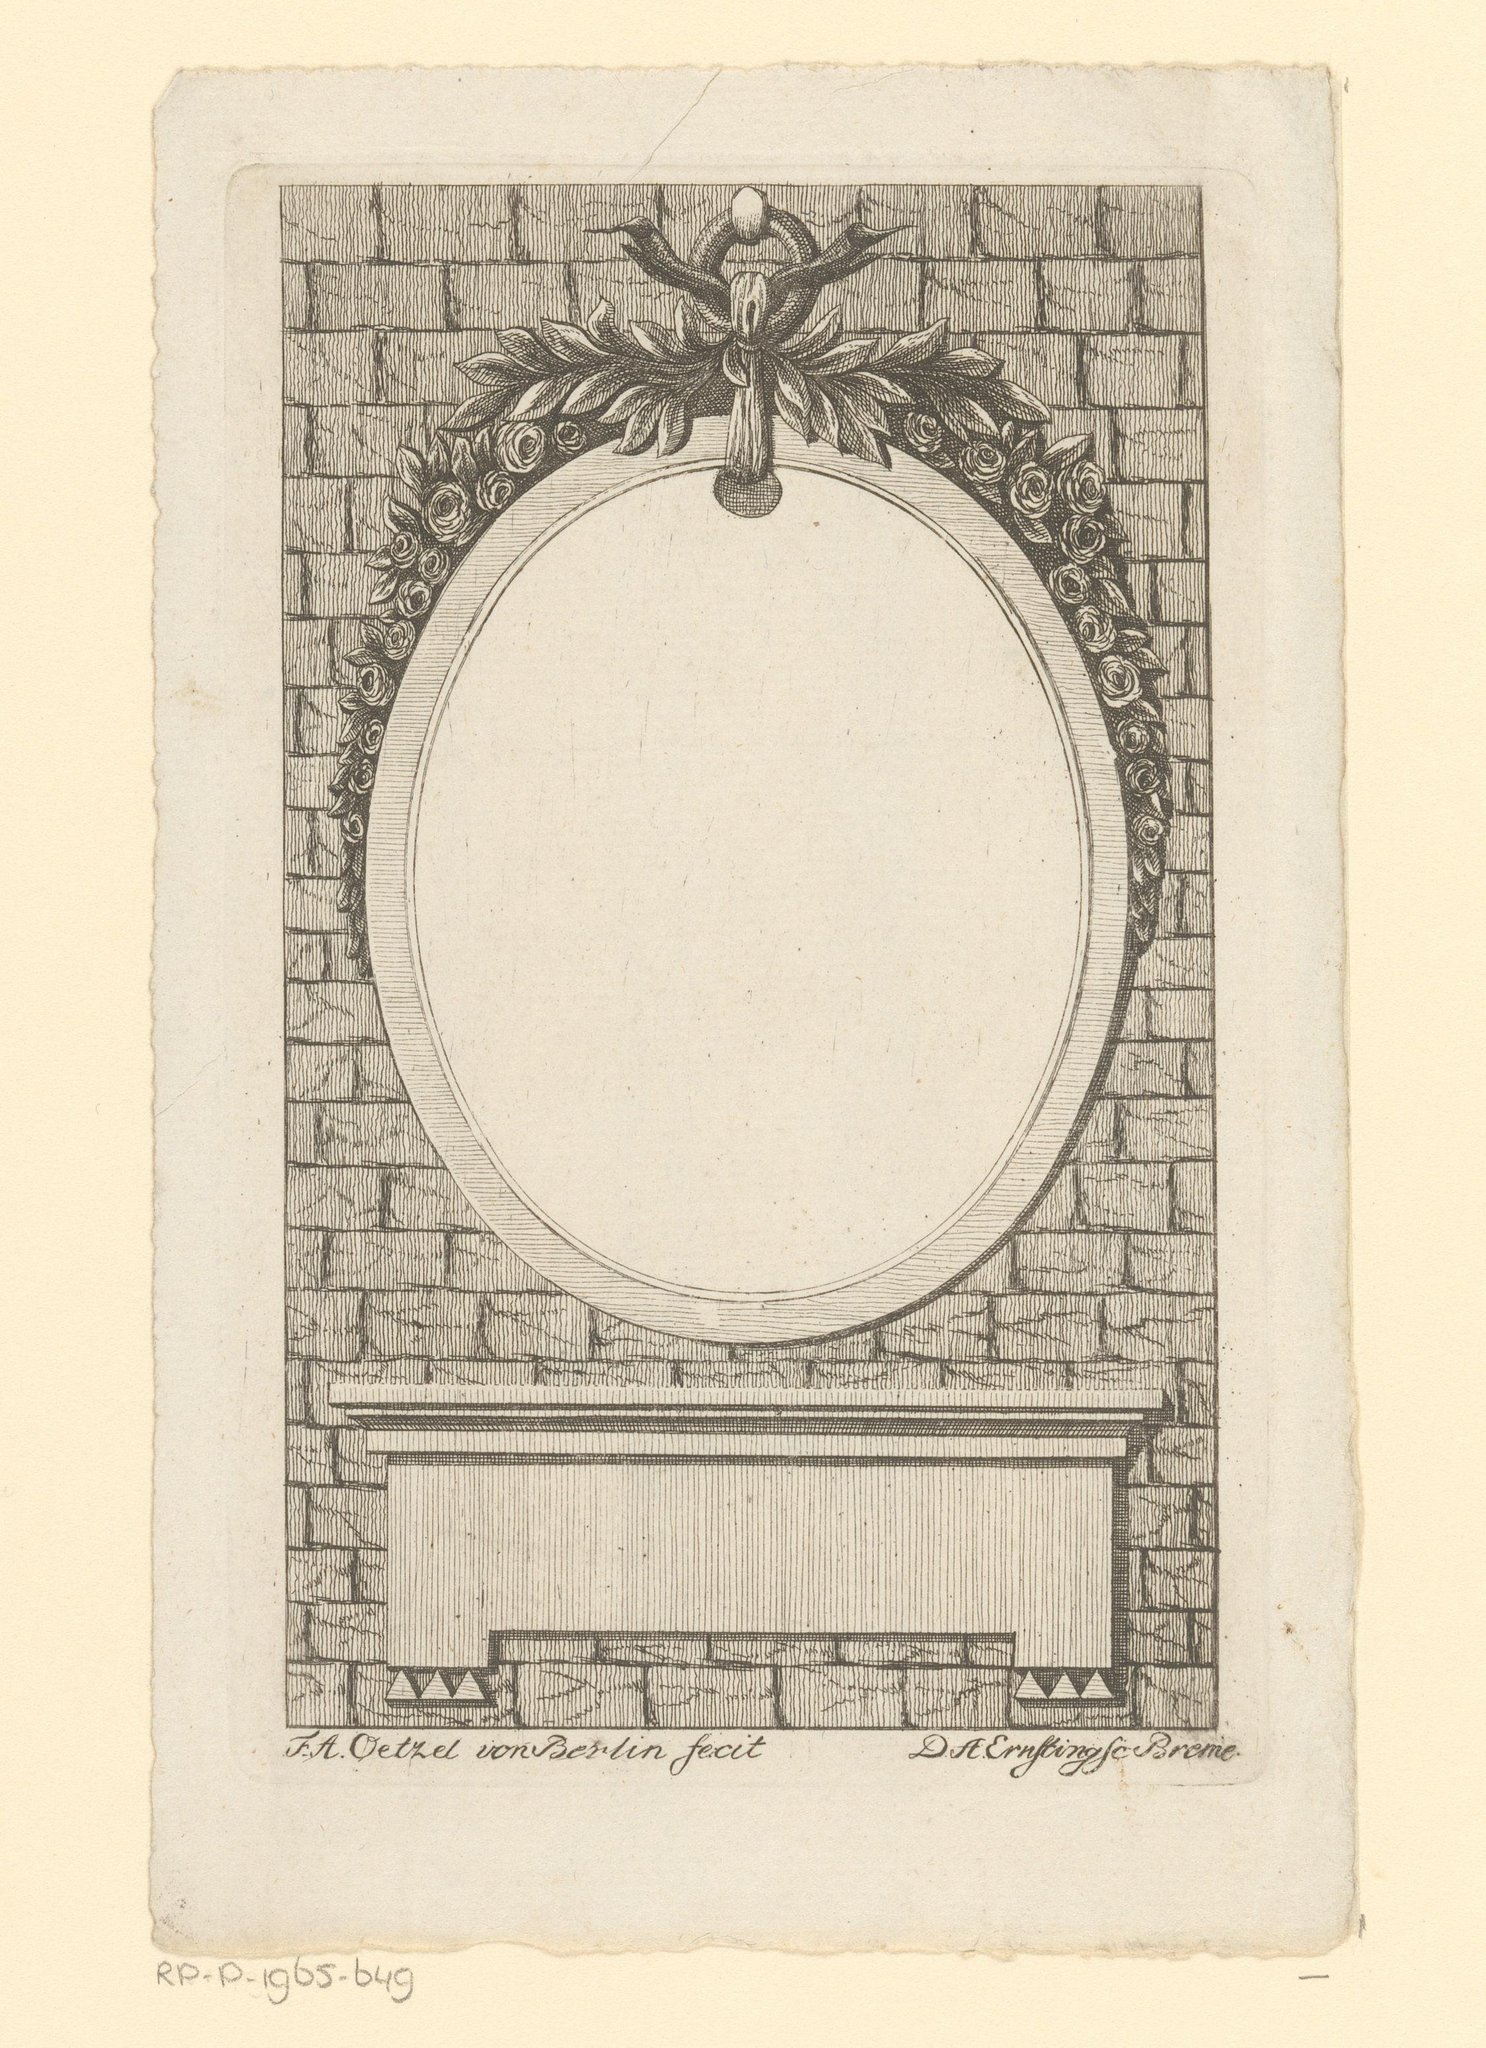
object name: ornament print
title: Ovale omlijsting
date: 1760-1820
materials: paper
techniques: etching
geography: bremen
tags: ornaments ~ art (+ framing decorations)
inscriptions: collector's mark: Lugt 2760, collector's mark: Lugt 2228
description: Tegen een muur hangt een ovale omlijsting, aan de bovenzijde met rozen omringd.